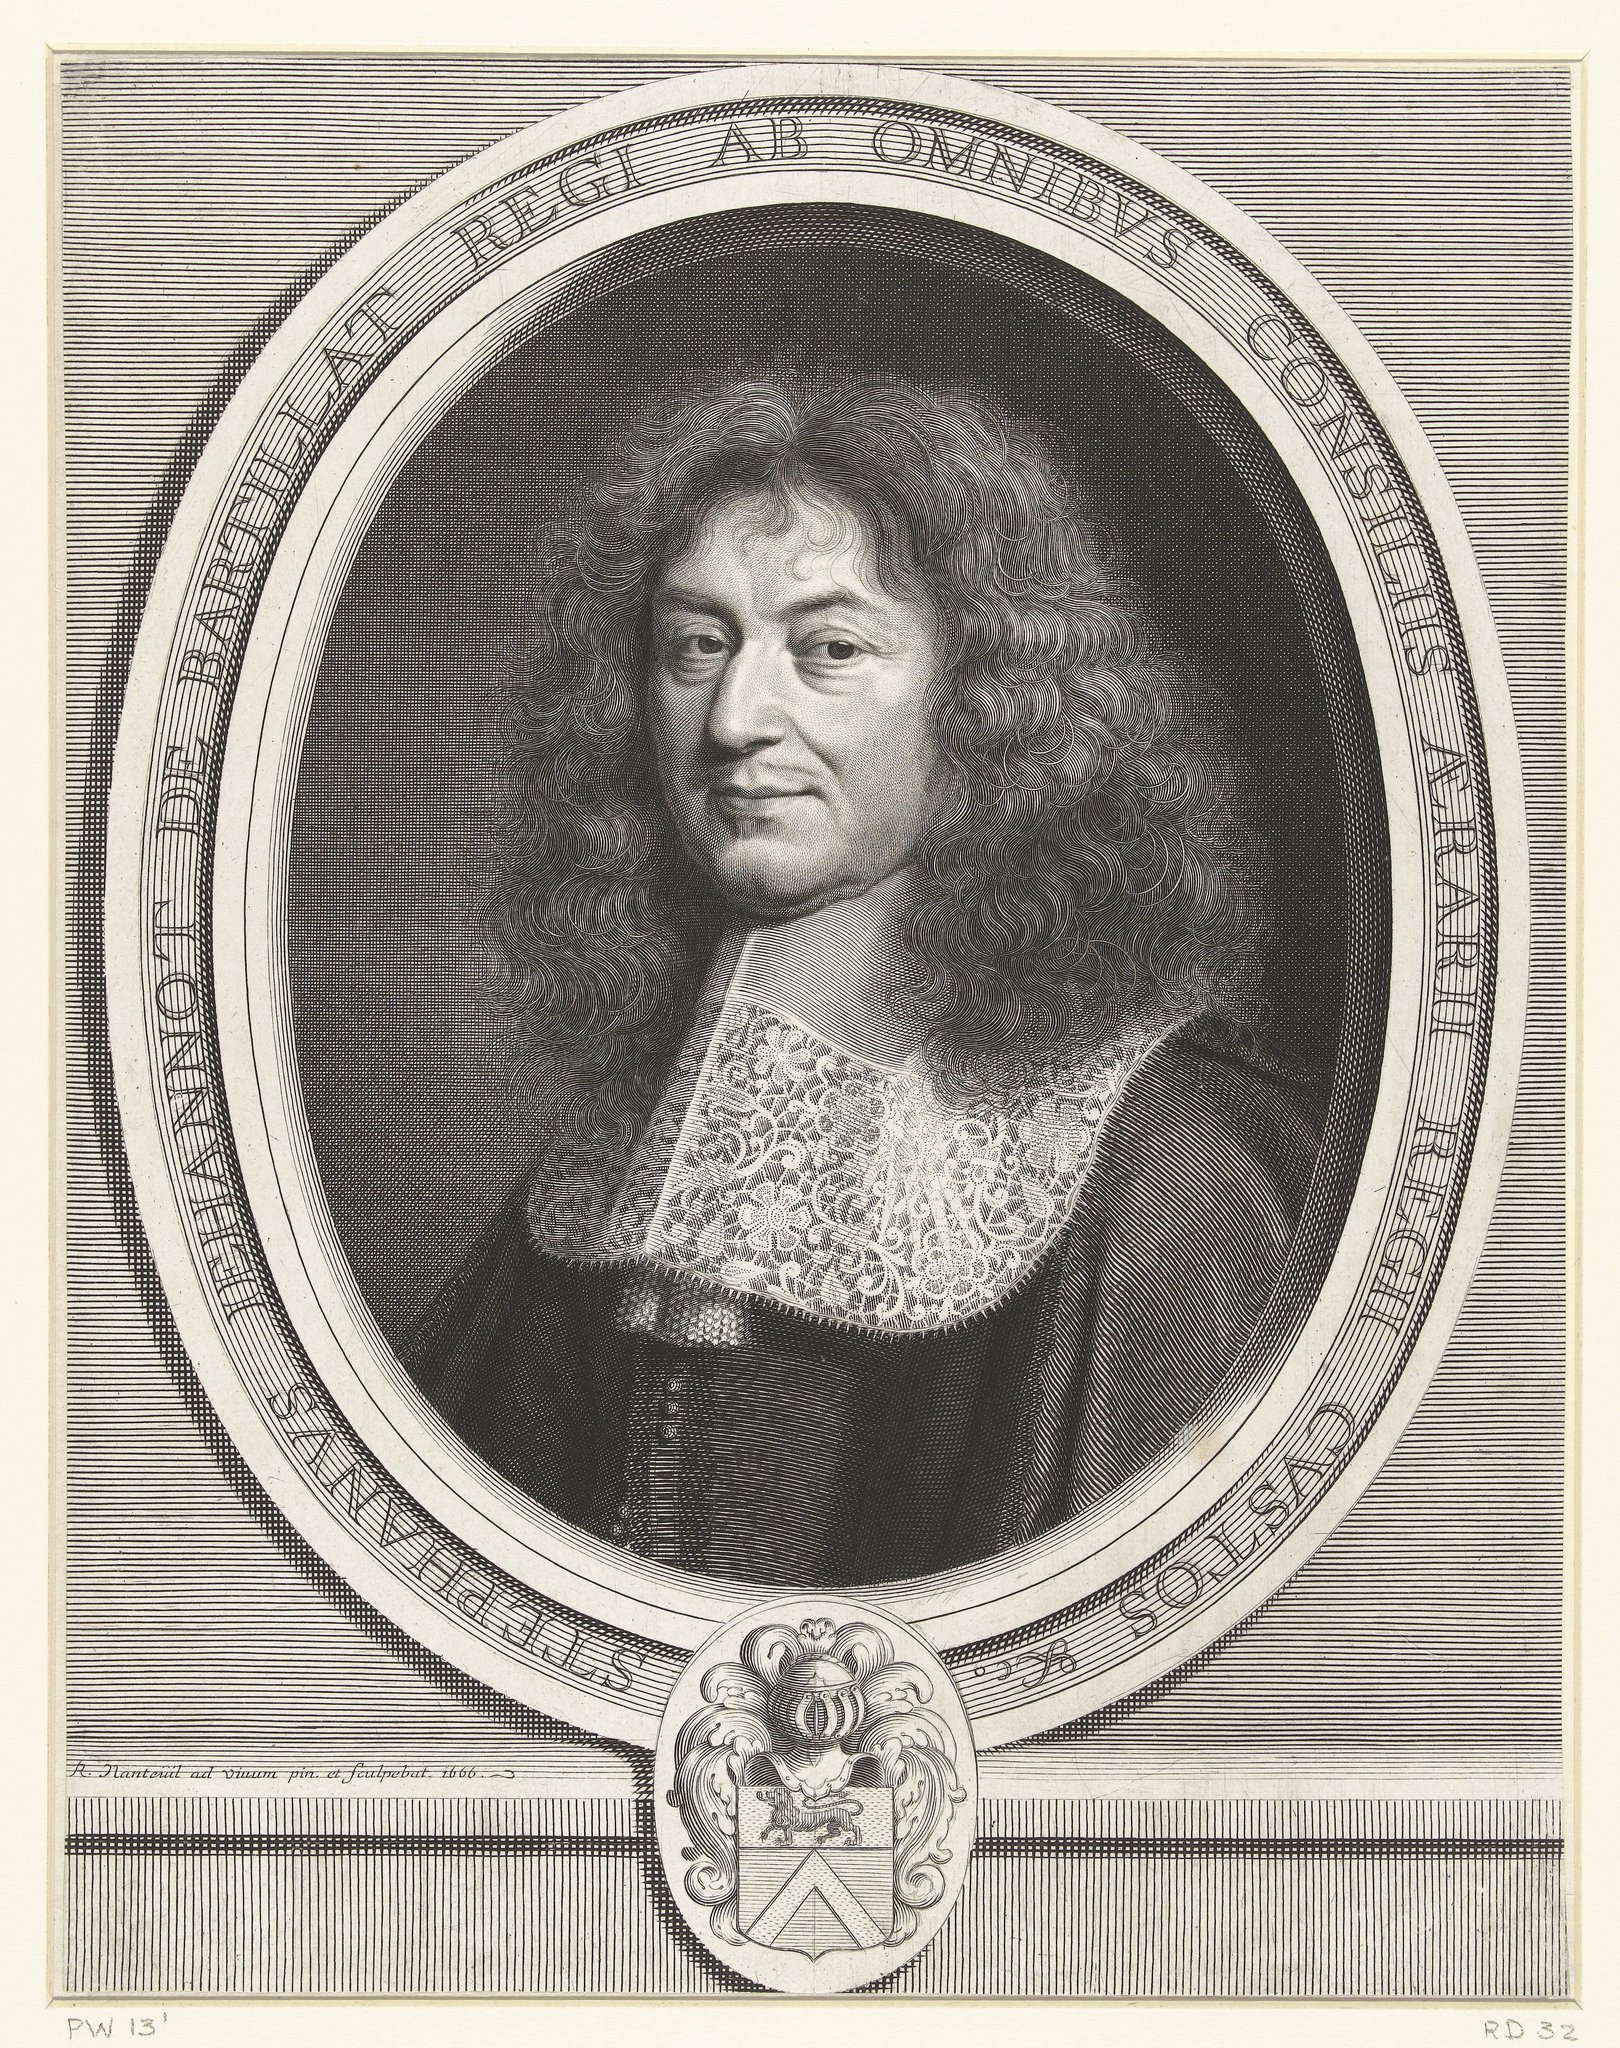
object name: print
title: Portret van Etienne Jehannot de Bartillat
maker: robert nanteuil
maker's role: print maker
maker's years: 1623-1678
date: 1666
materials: paper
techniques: engraving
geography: france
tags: etienne jehannot de bartillat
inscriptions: collector's mark: Lugt 2228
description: Portret van Etienne Jehannot de Bartillat, in een ovale omlijsting met tekst. Onderaan zijn wapen.